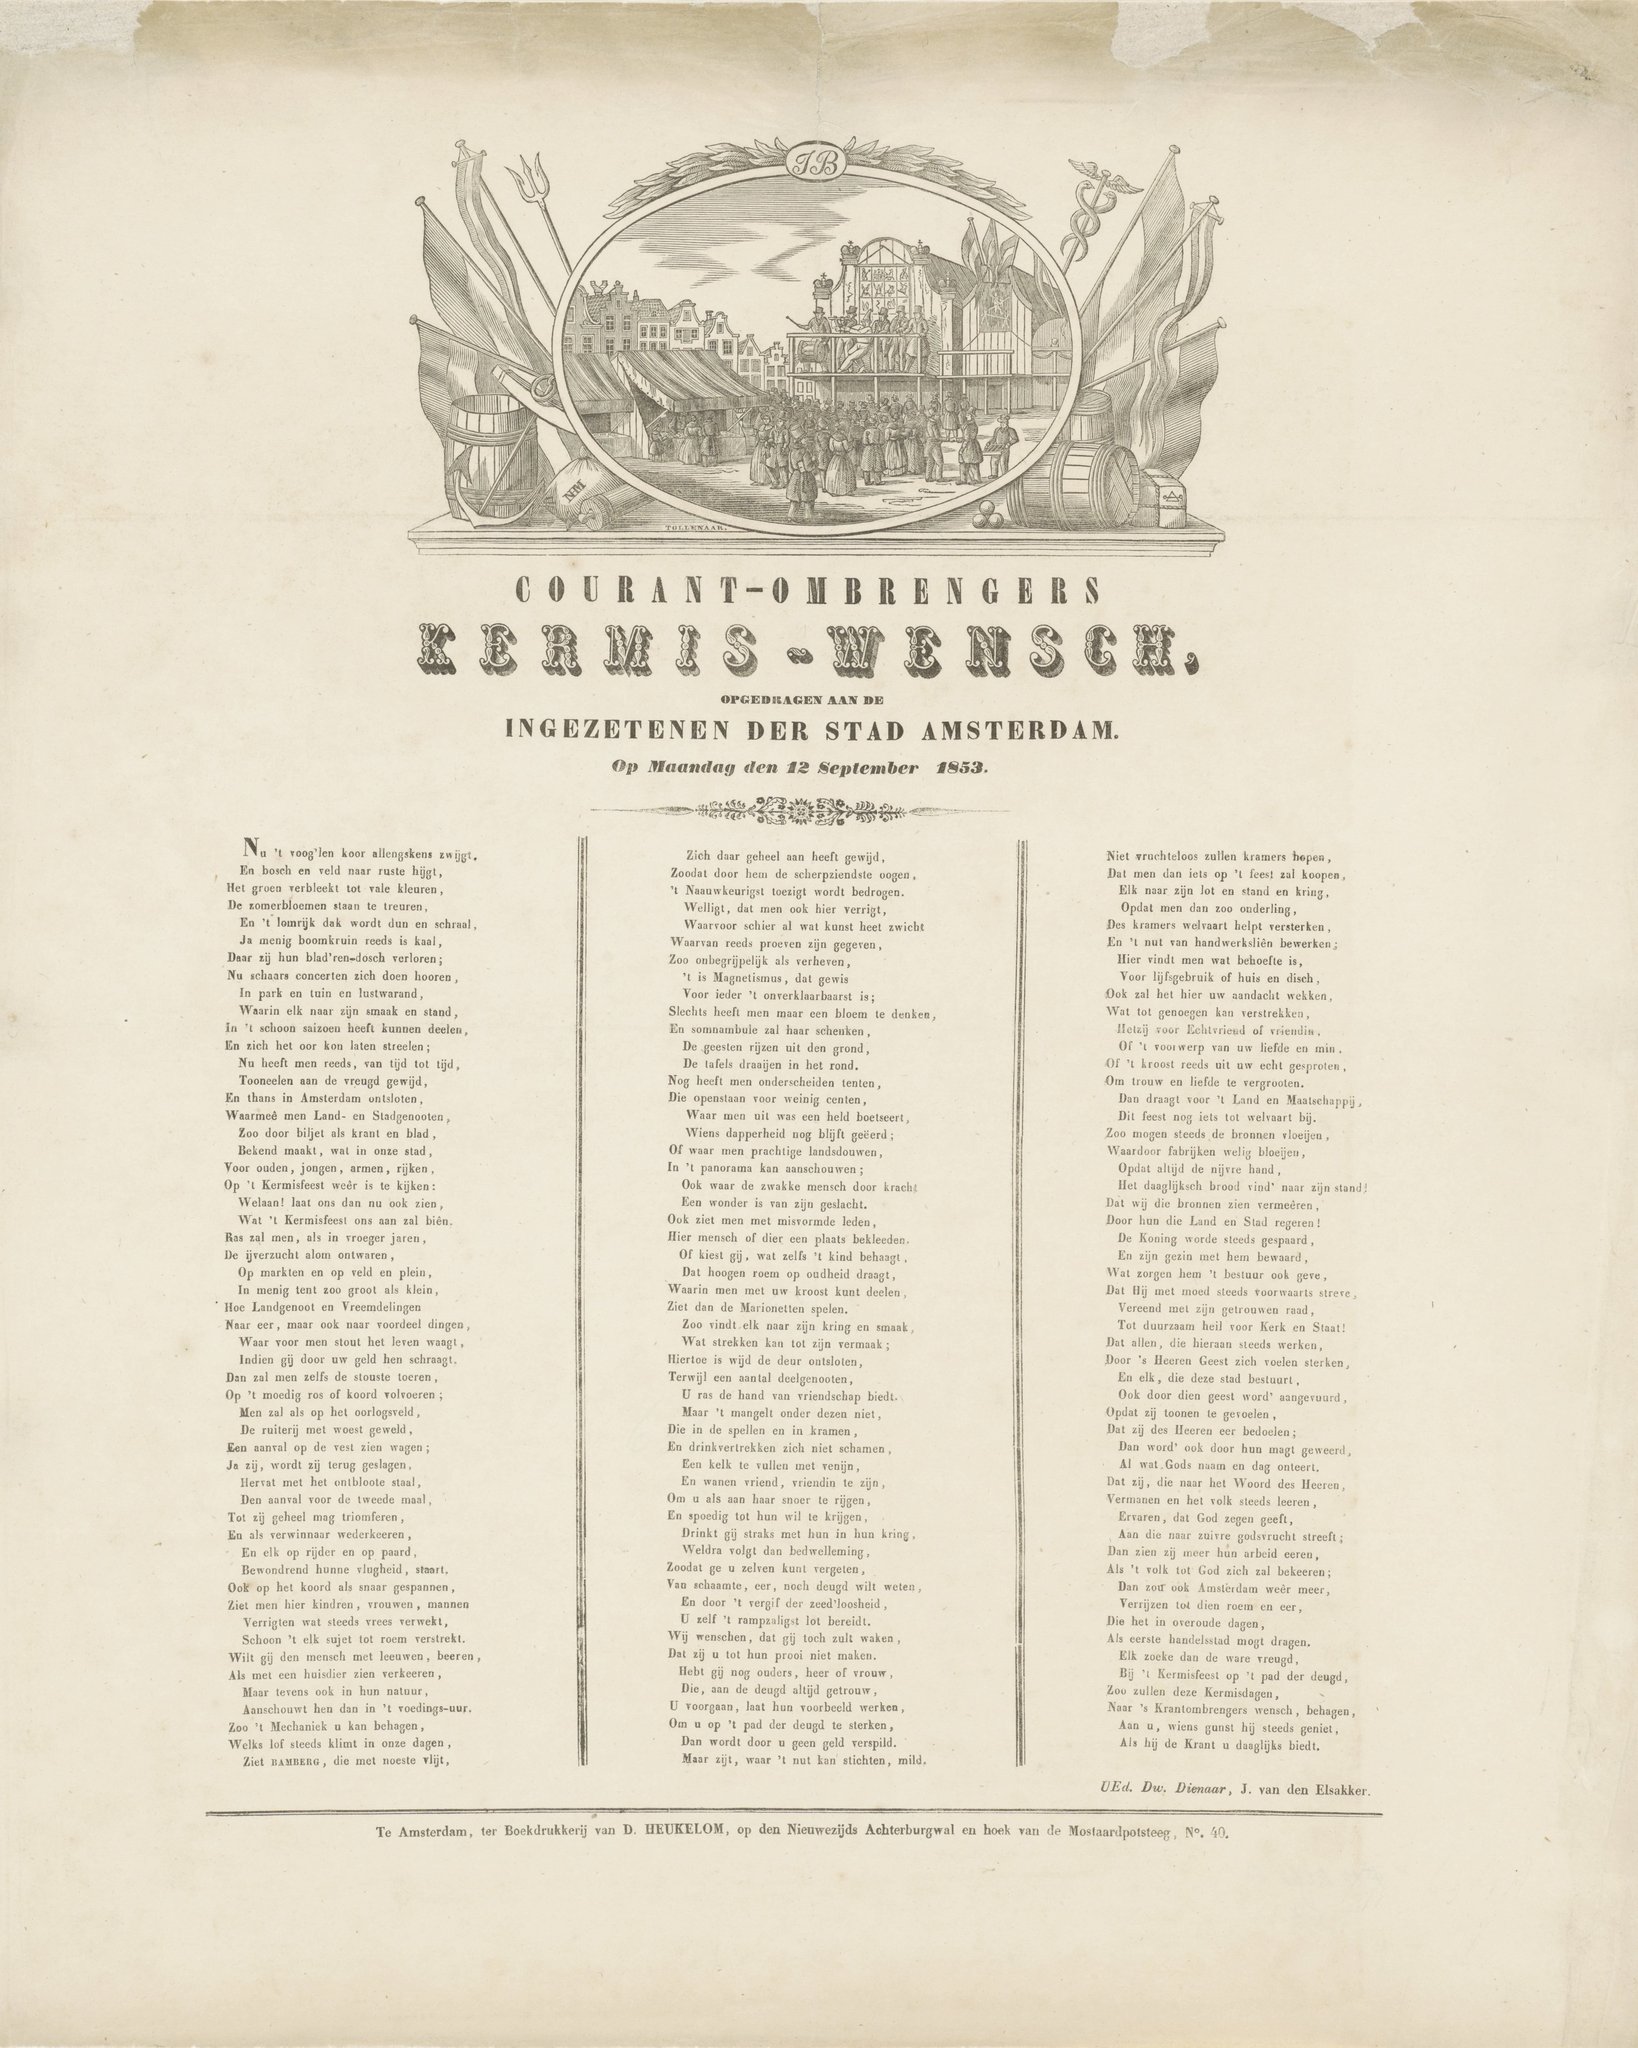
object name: print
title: Courant-Ombrengers Kermis-Wensch (...) 1853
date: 1853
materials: paper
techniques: letterpress printing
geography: amsterdam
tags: pleasure fair and circus, amsterdam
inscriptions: collector's mark: Lugt 2228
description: Kermisprent namens de ombrengers van couranten (krantenbezorgers) te Amsterdam, 12 september 1853. Bovenaan een medaillon met een gezicht op de kermis op de Botermarkt. Onderaan een gedicht in drie kolommen. Van de courantombrenger: J. van den Elsakker.